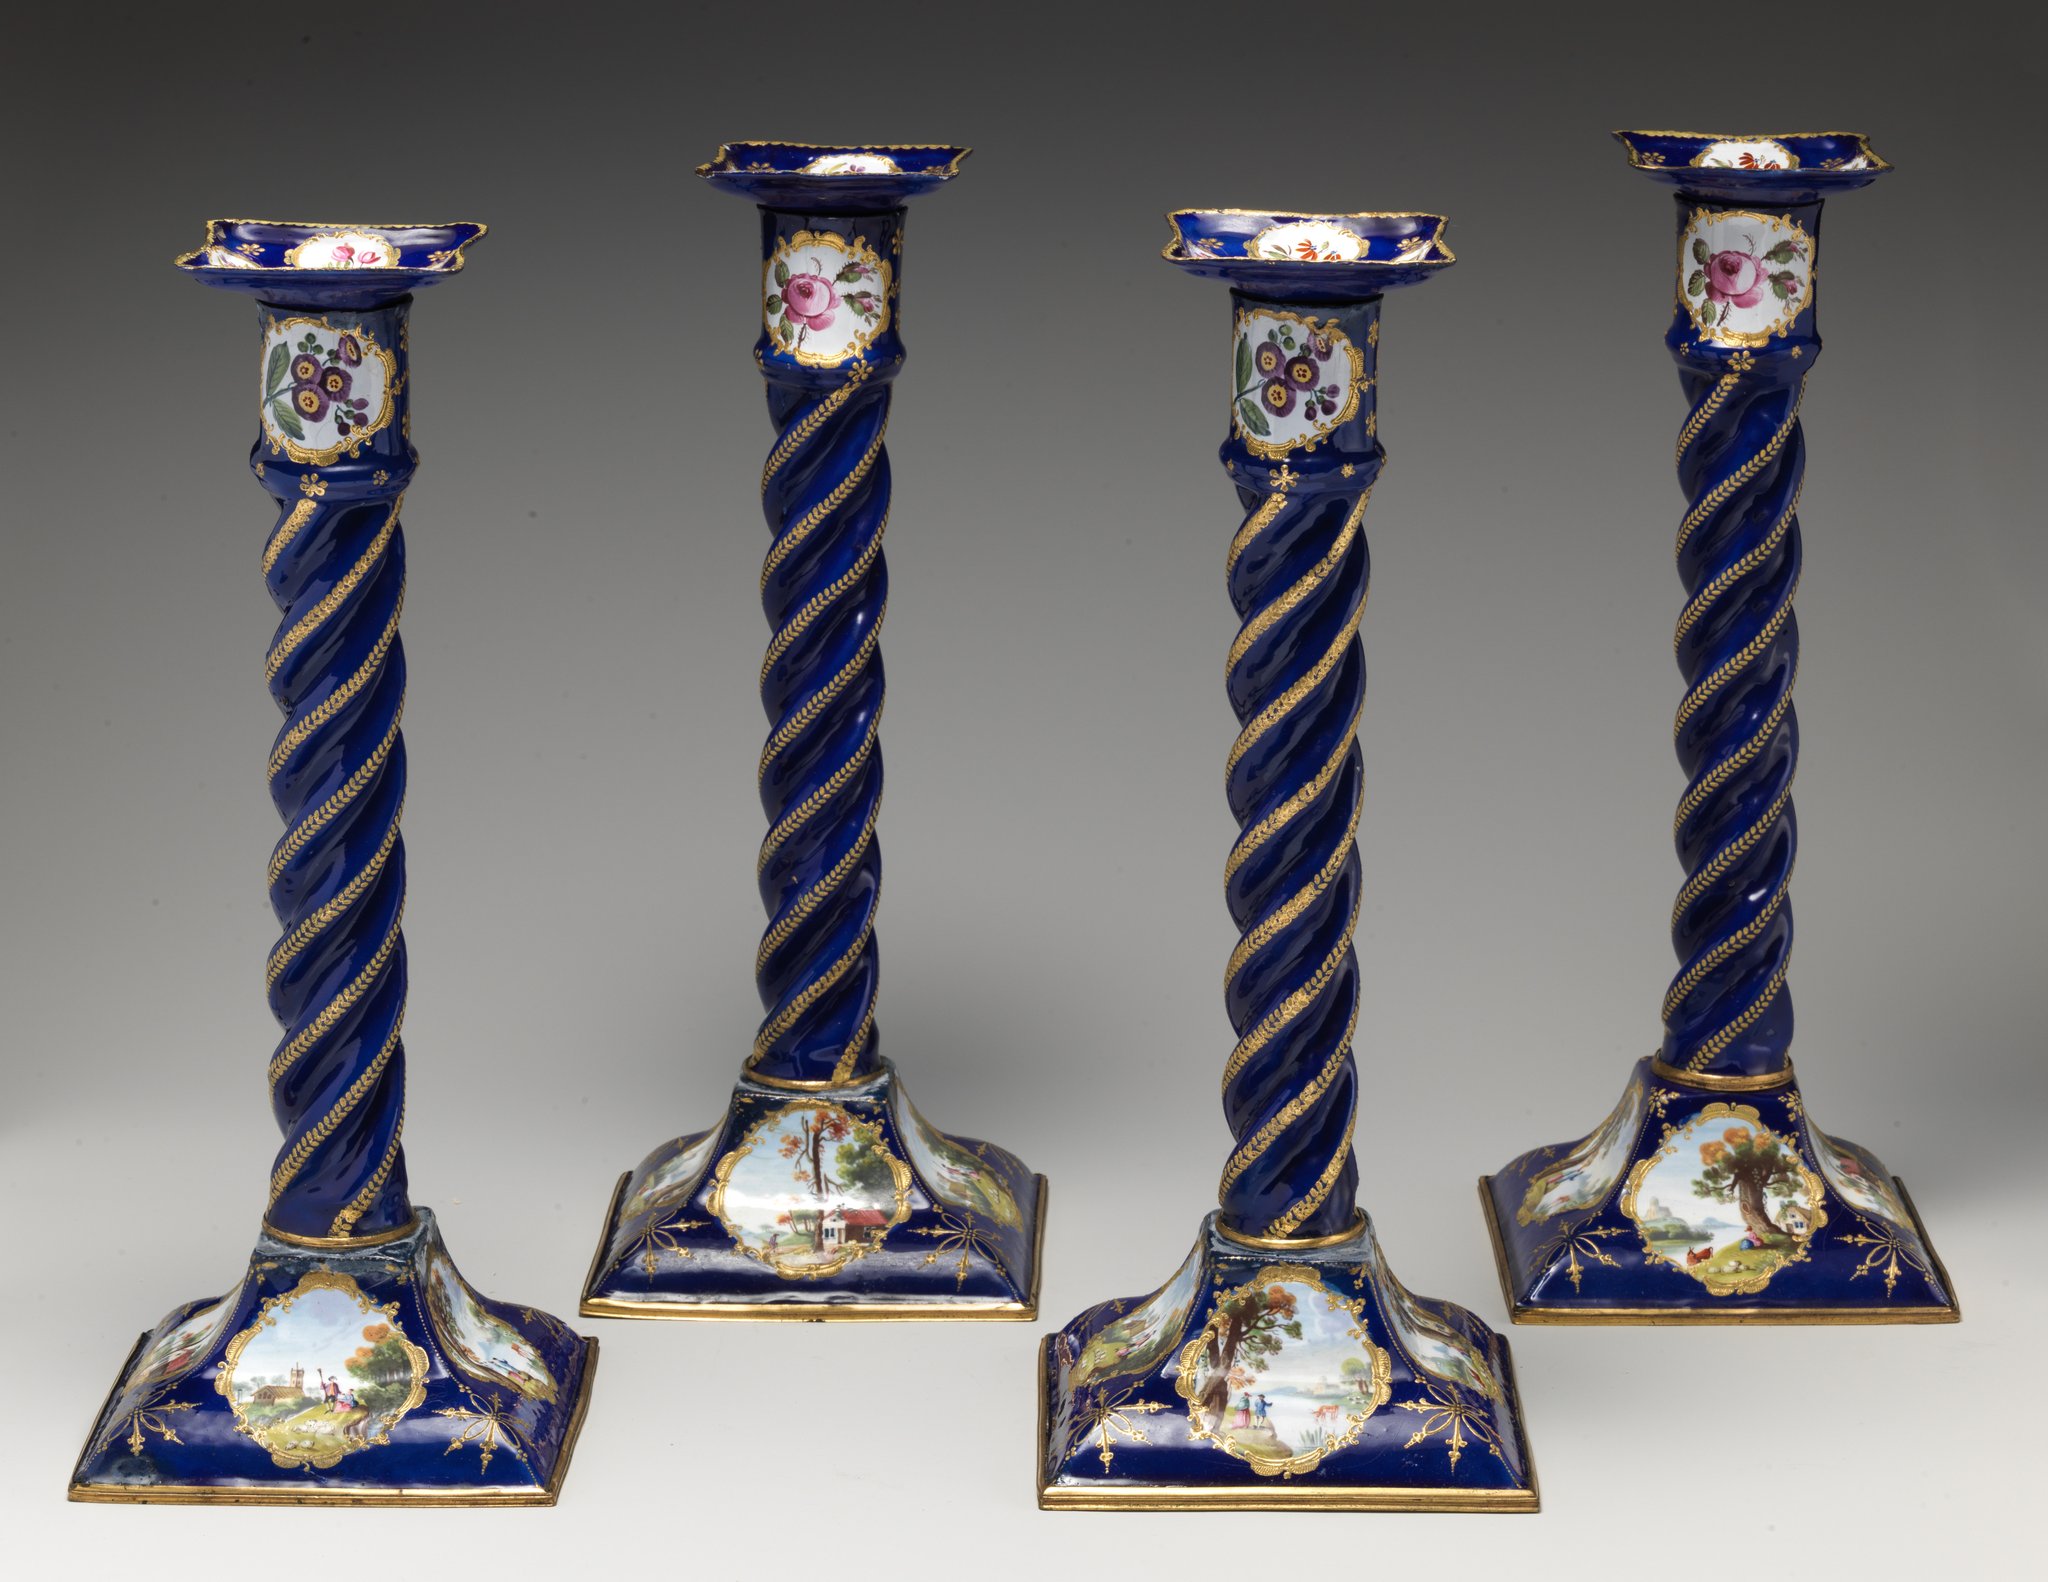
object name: candlestick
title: Spiral Candlesticks (4)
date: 1780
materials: copper, enamel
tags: landscapes